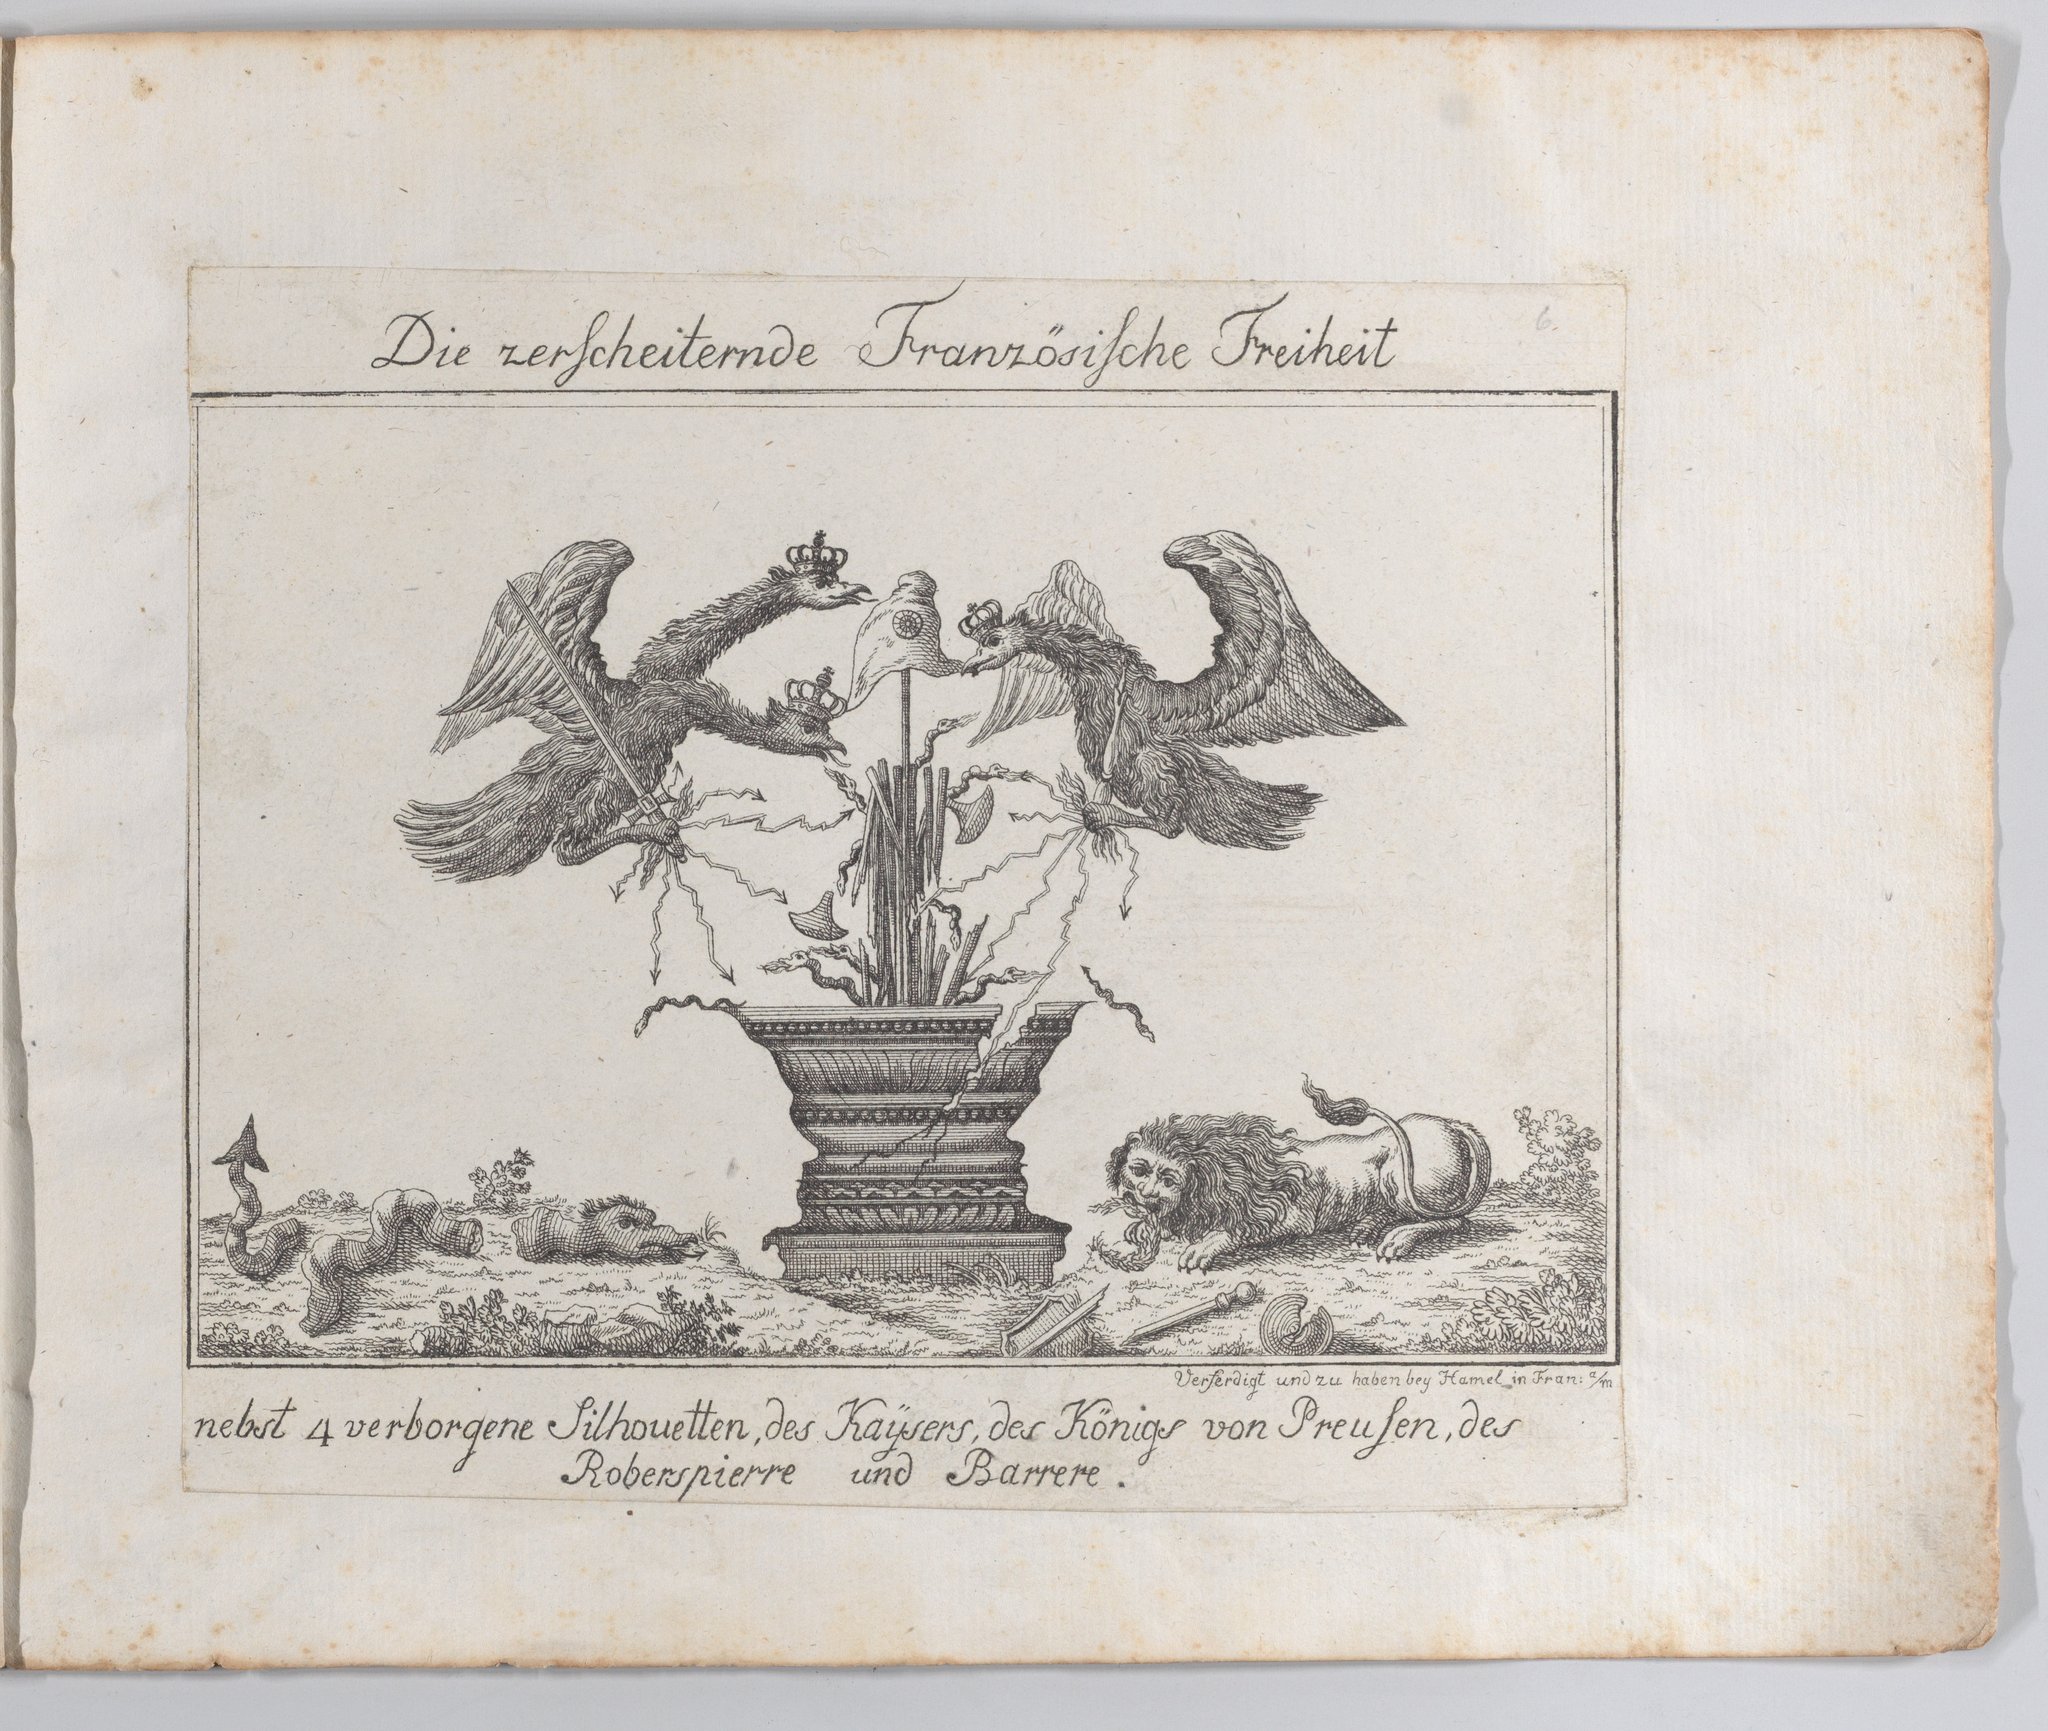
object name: album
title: Allegory representing the freedom of France with four silhouettes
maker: anonymous, german, 18th century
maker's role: artist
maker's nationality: german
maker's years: 1700-1800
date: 1793-1800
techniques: etching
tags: eagles,emperors,kings,lions